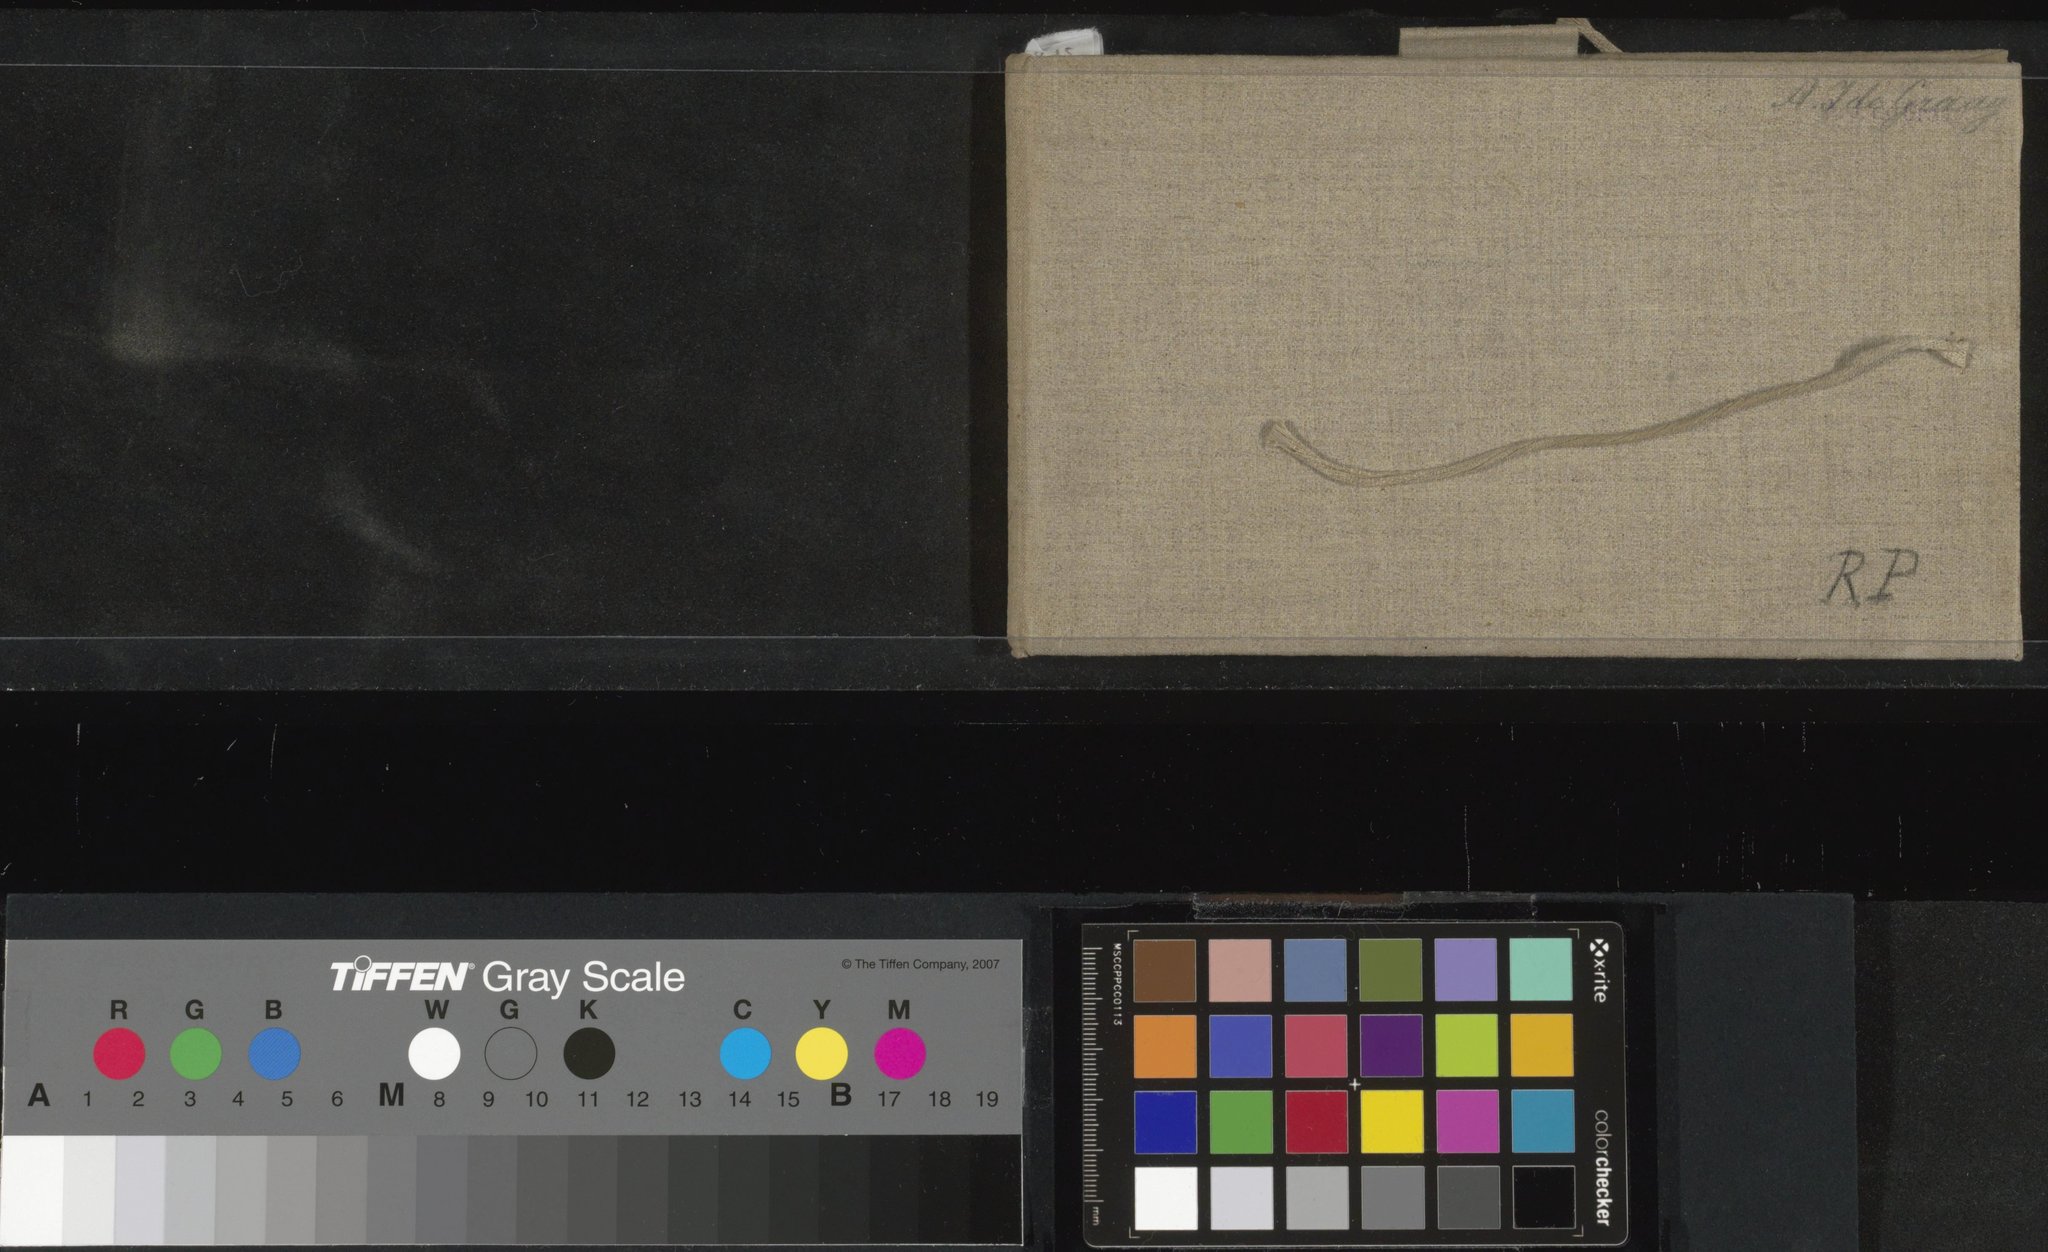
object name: sketchbook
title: Schetsboek met 22 bladen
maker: julie de graag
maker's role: draughtsman, print maker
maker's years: 1877-1924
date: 1892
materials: cardboard, ink, linen, paper, pencil, watercolor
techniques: brush, pen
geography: scheveningen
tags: adult woman, cat, adult man, dog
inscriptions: retailer's mark: ‘J.G.TENZER/ Kunsthändler/ und/ Maler/ Piet Heinstr. 13c/ HAAG’, collector's mark: Lugt 2228a, annotation: ‘RP’, date and inscription: ‘0,60/ +- 1892/ 2650/I’, annotation: ‘143’, signature: ‘A.J. de Graag’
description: Schetsboek bestaande uit 22 bladen en twee losse vellen met voornamelijk figuurstudies, portretten van familieleden en vrienden, karikaturale zelfportretten, honden en katten. Enkele van de schetsen zijn door Cato, de zus van Julie de Graag, en een vriend of familielid genaamd Karel gemaakt.